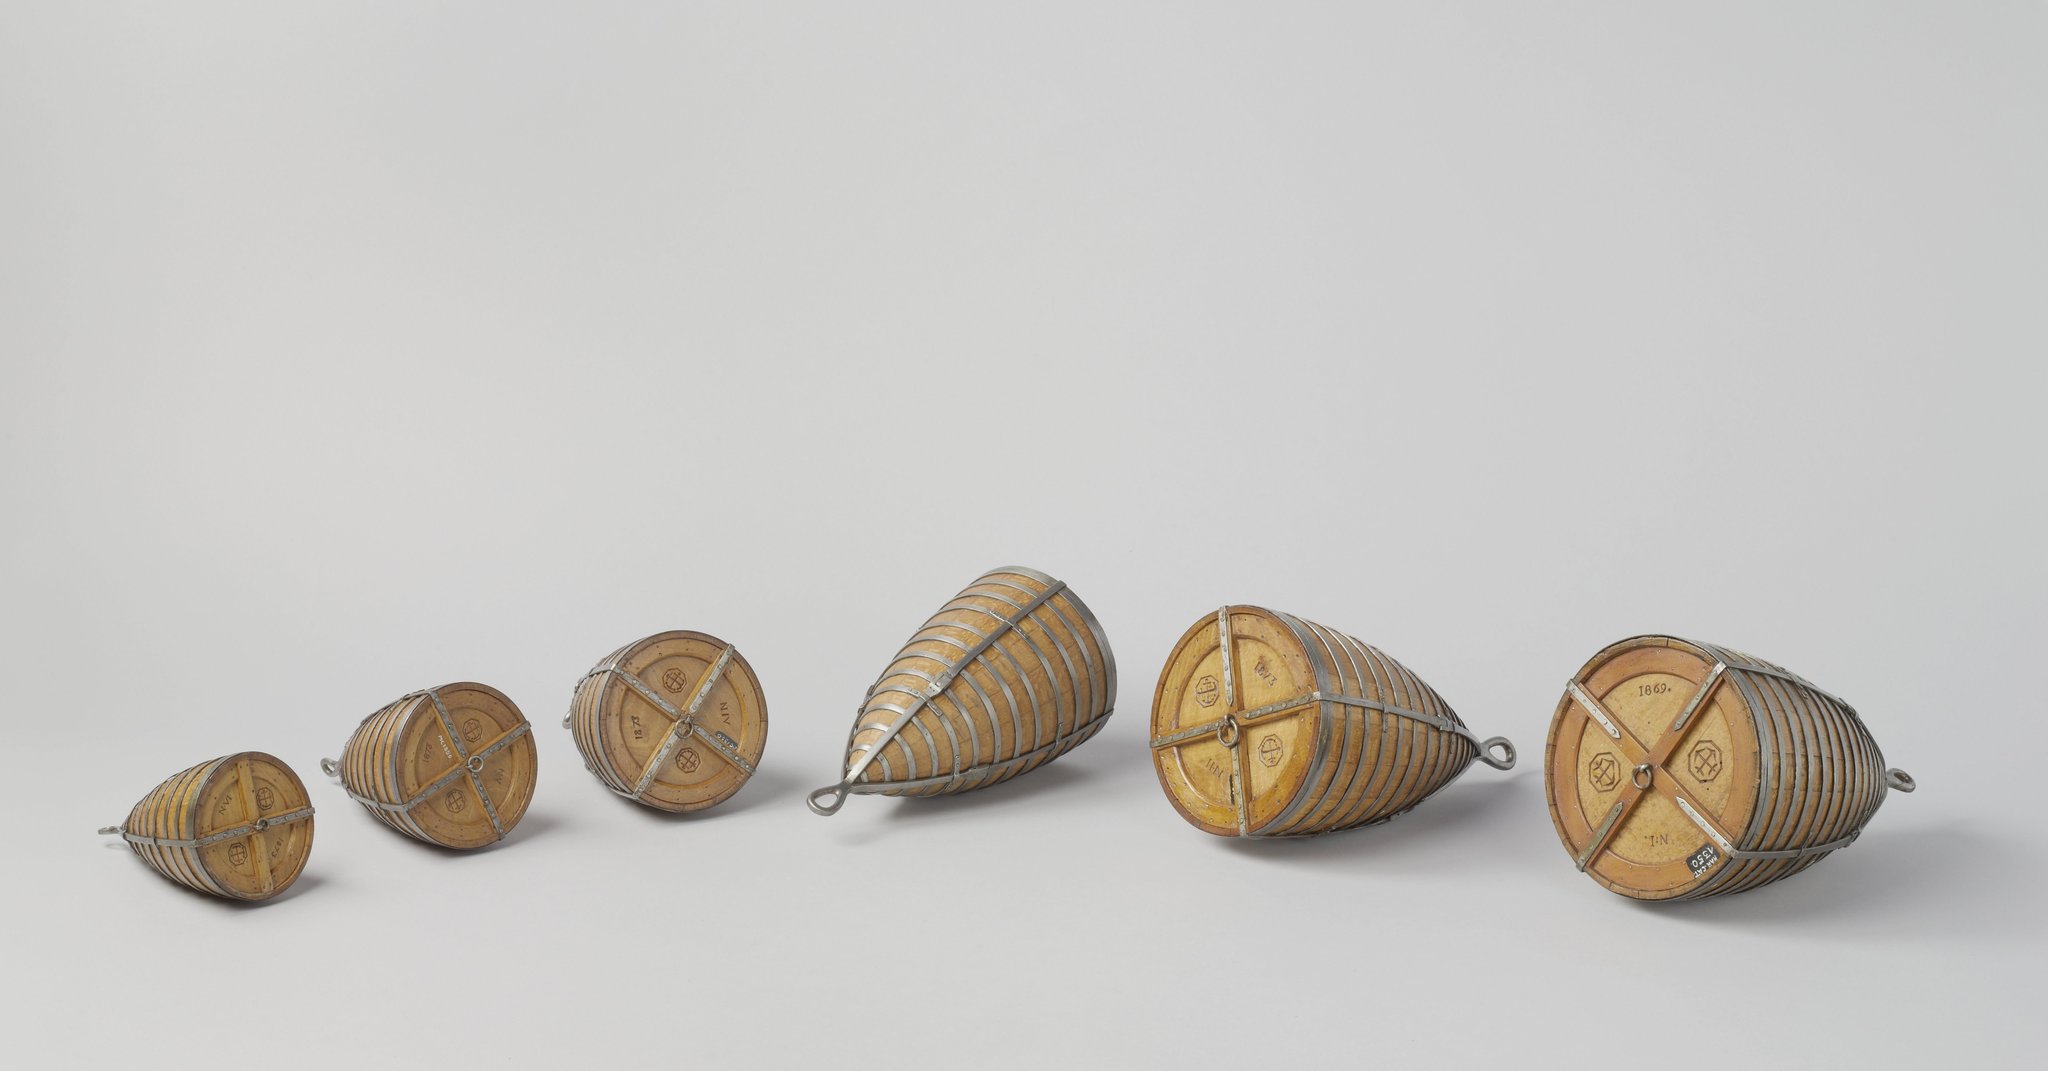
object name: demonstration model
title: Model of a Buoy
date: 1869-1873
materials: iron, wood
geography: enkhuizen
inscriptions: inscription: ‘N·V / 1873’, monogram: crossed anchors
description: Model van een boei (buikton) met een conisch lichaam met een scherp uiteinde en een ronde platte bovenkant met een ring in het midden. Zoals een vat is zij samengesteld uit duigen en hoepels. Onderaan zit een oog voor de ankerketting. Gemerkt met gekruiste ankers. Model behoort bij serie van zes boeien van verschillende formaten. Schaal 1:10 (archief).